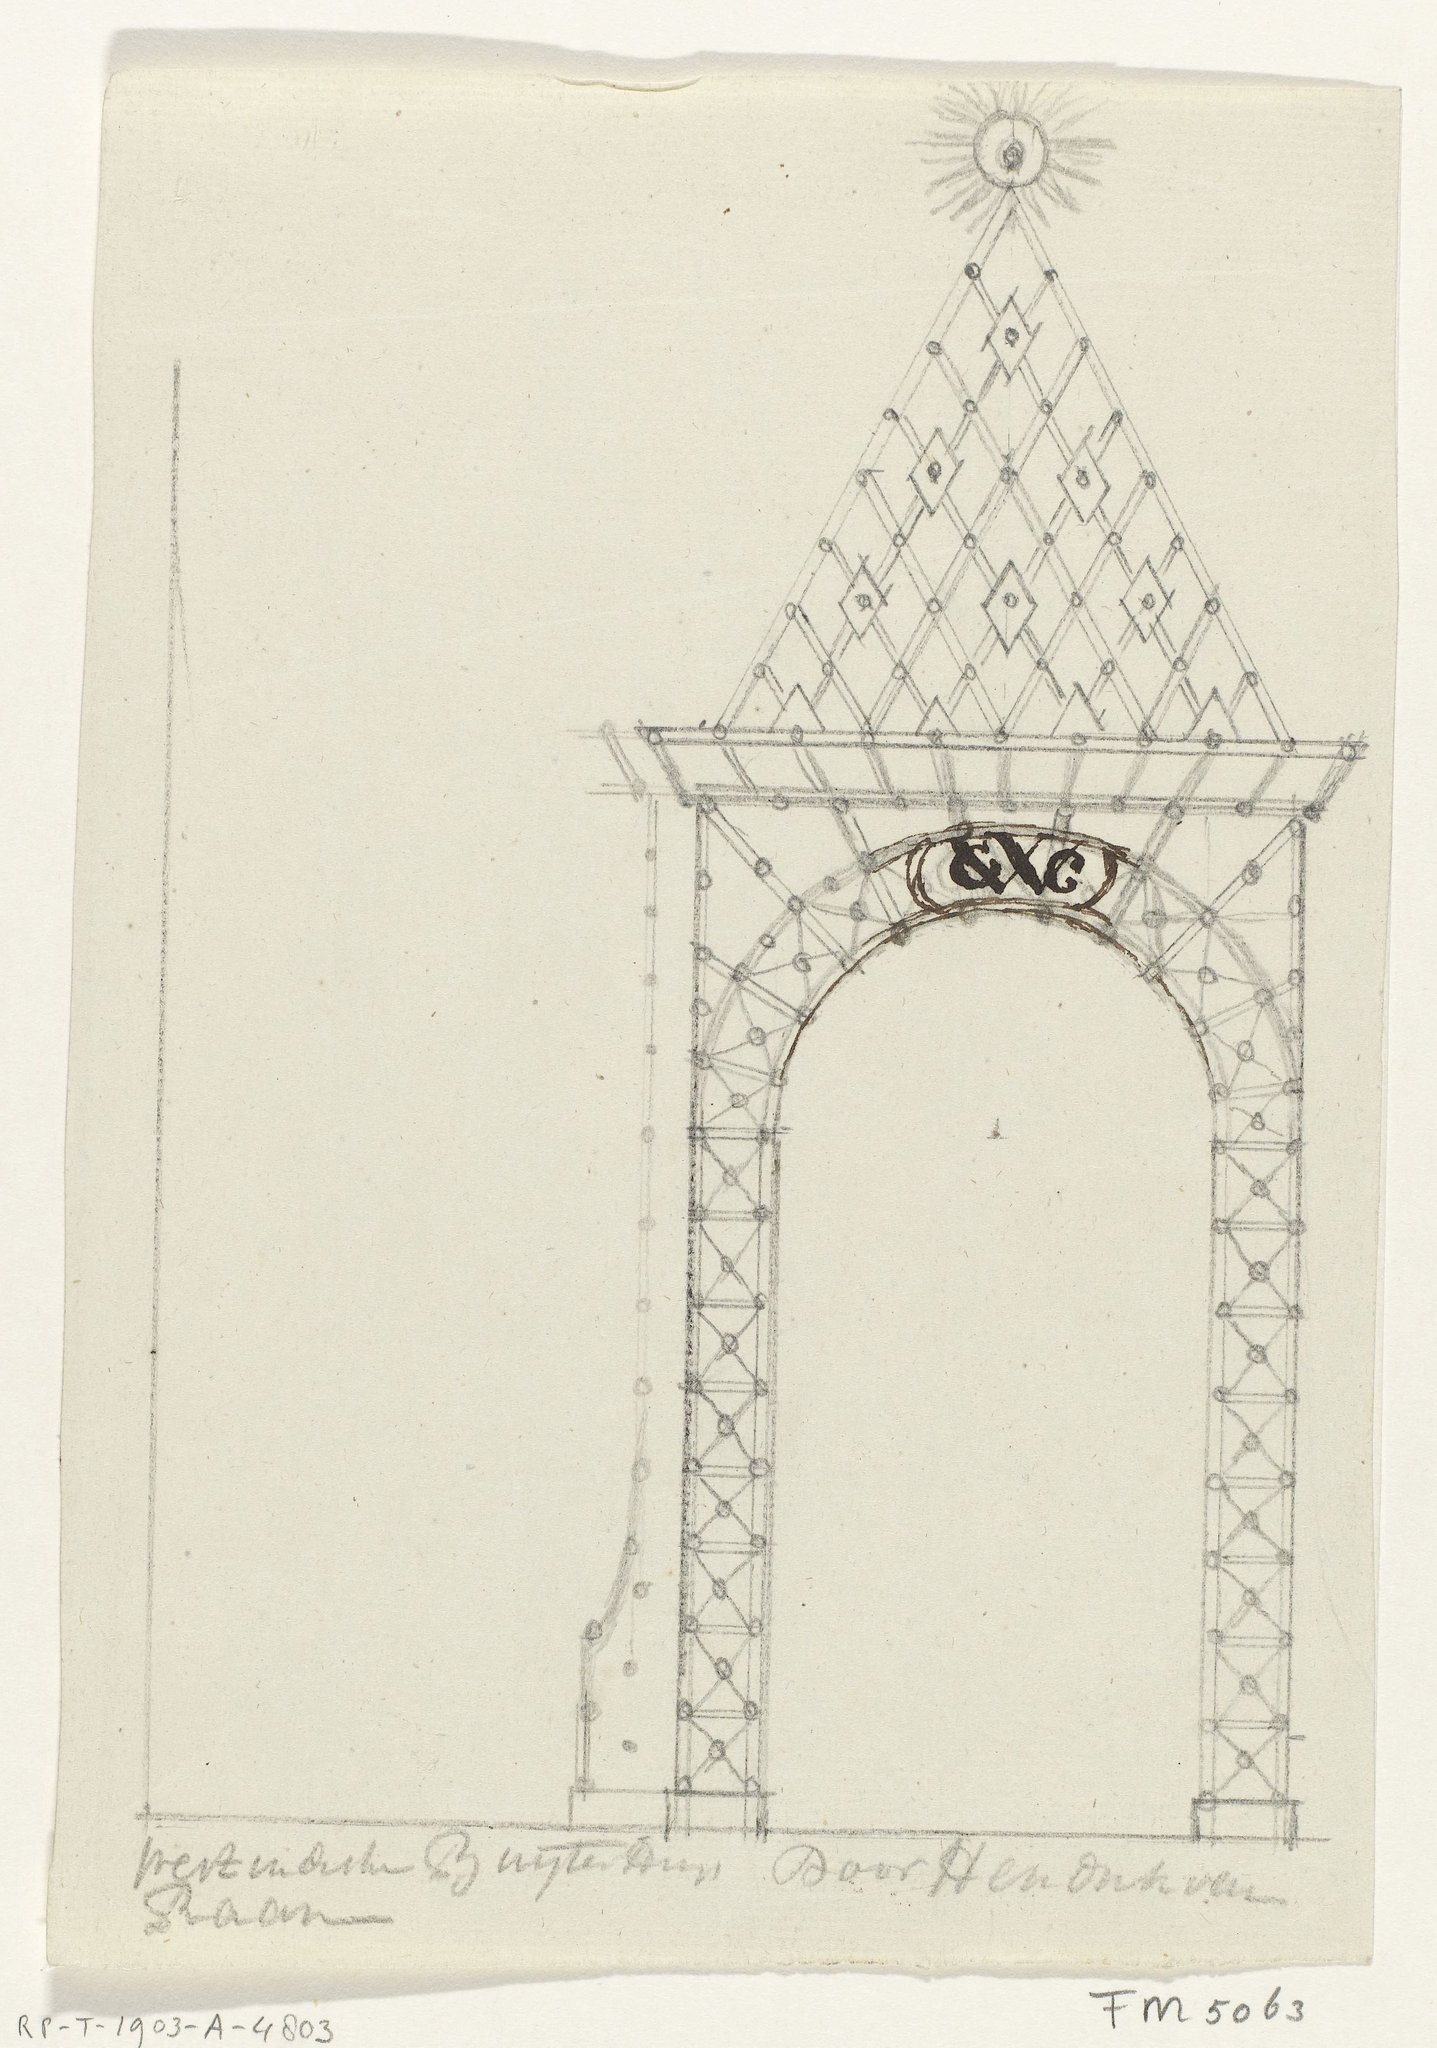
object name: drawing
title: Ontwerp voor illuminatie van het West-Indische buitenhuis te Amsterdam, 1788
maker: hendrik g. van raan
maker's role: draughtsman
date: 1788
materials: ink, paper, pencil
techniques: writing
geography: amsterdam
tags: the hague, william v (prince of orange), bonfire, fire-works (+ illumination, fire-works ~ festive activities), amsterdam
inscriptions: inscription: ‘Westindische Buytenhuys / Door Hendrik van Raan’, collector's mark: Lugt 2228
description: Ontwerp voor de illuminatie van het West-Indische buitenhuis te Amsterdam. Onderdeel van een groep van ontwerptekeningen van de architect Hendrik G. van Raan voor illuminaties en decoraties te Amsterdam op de 40ste verjaardag van prins Willem V op 8 maart 1788.